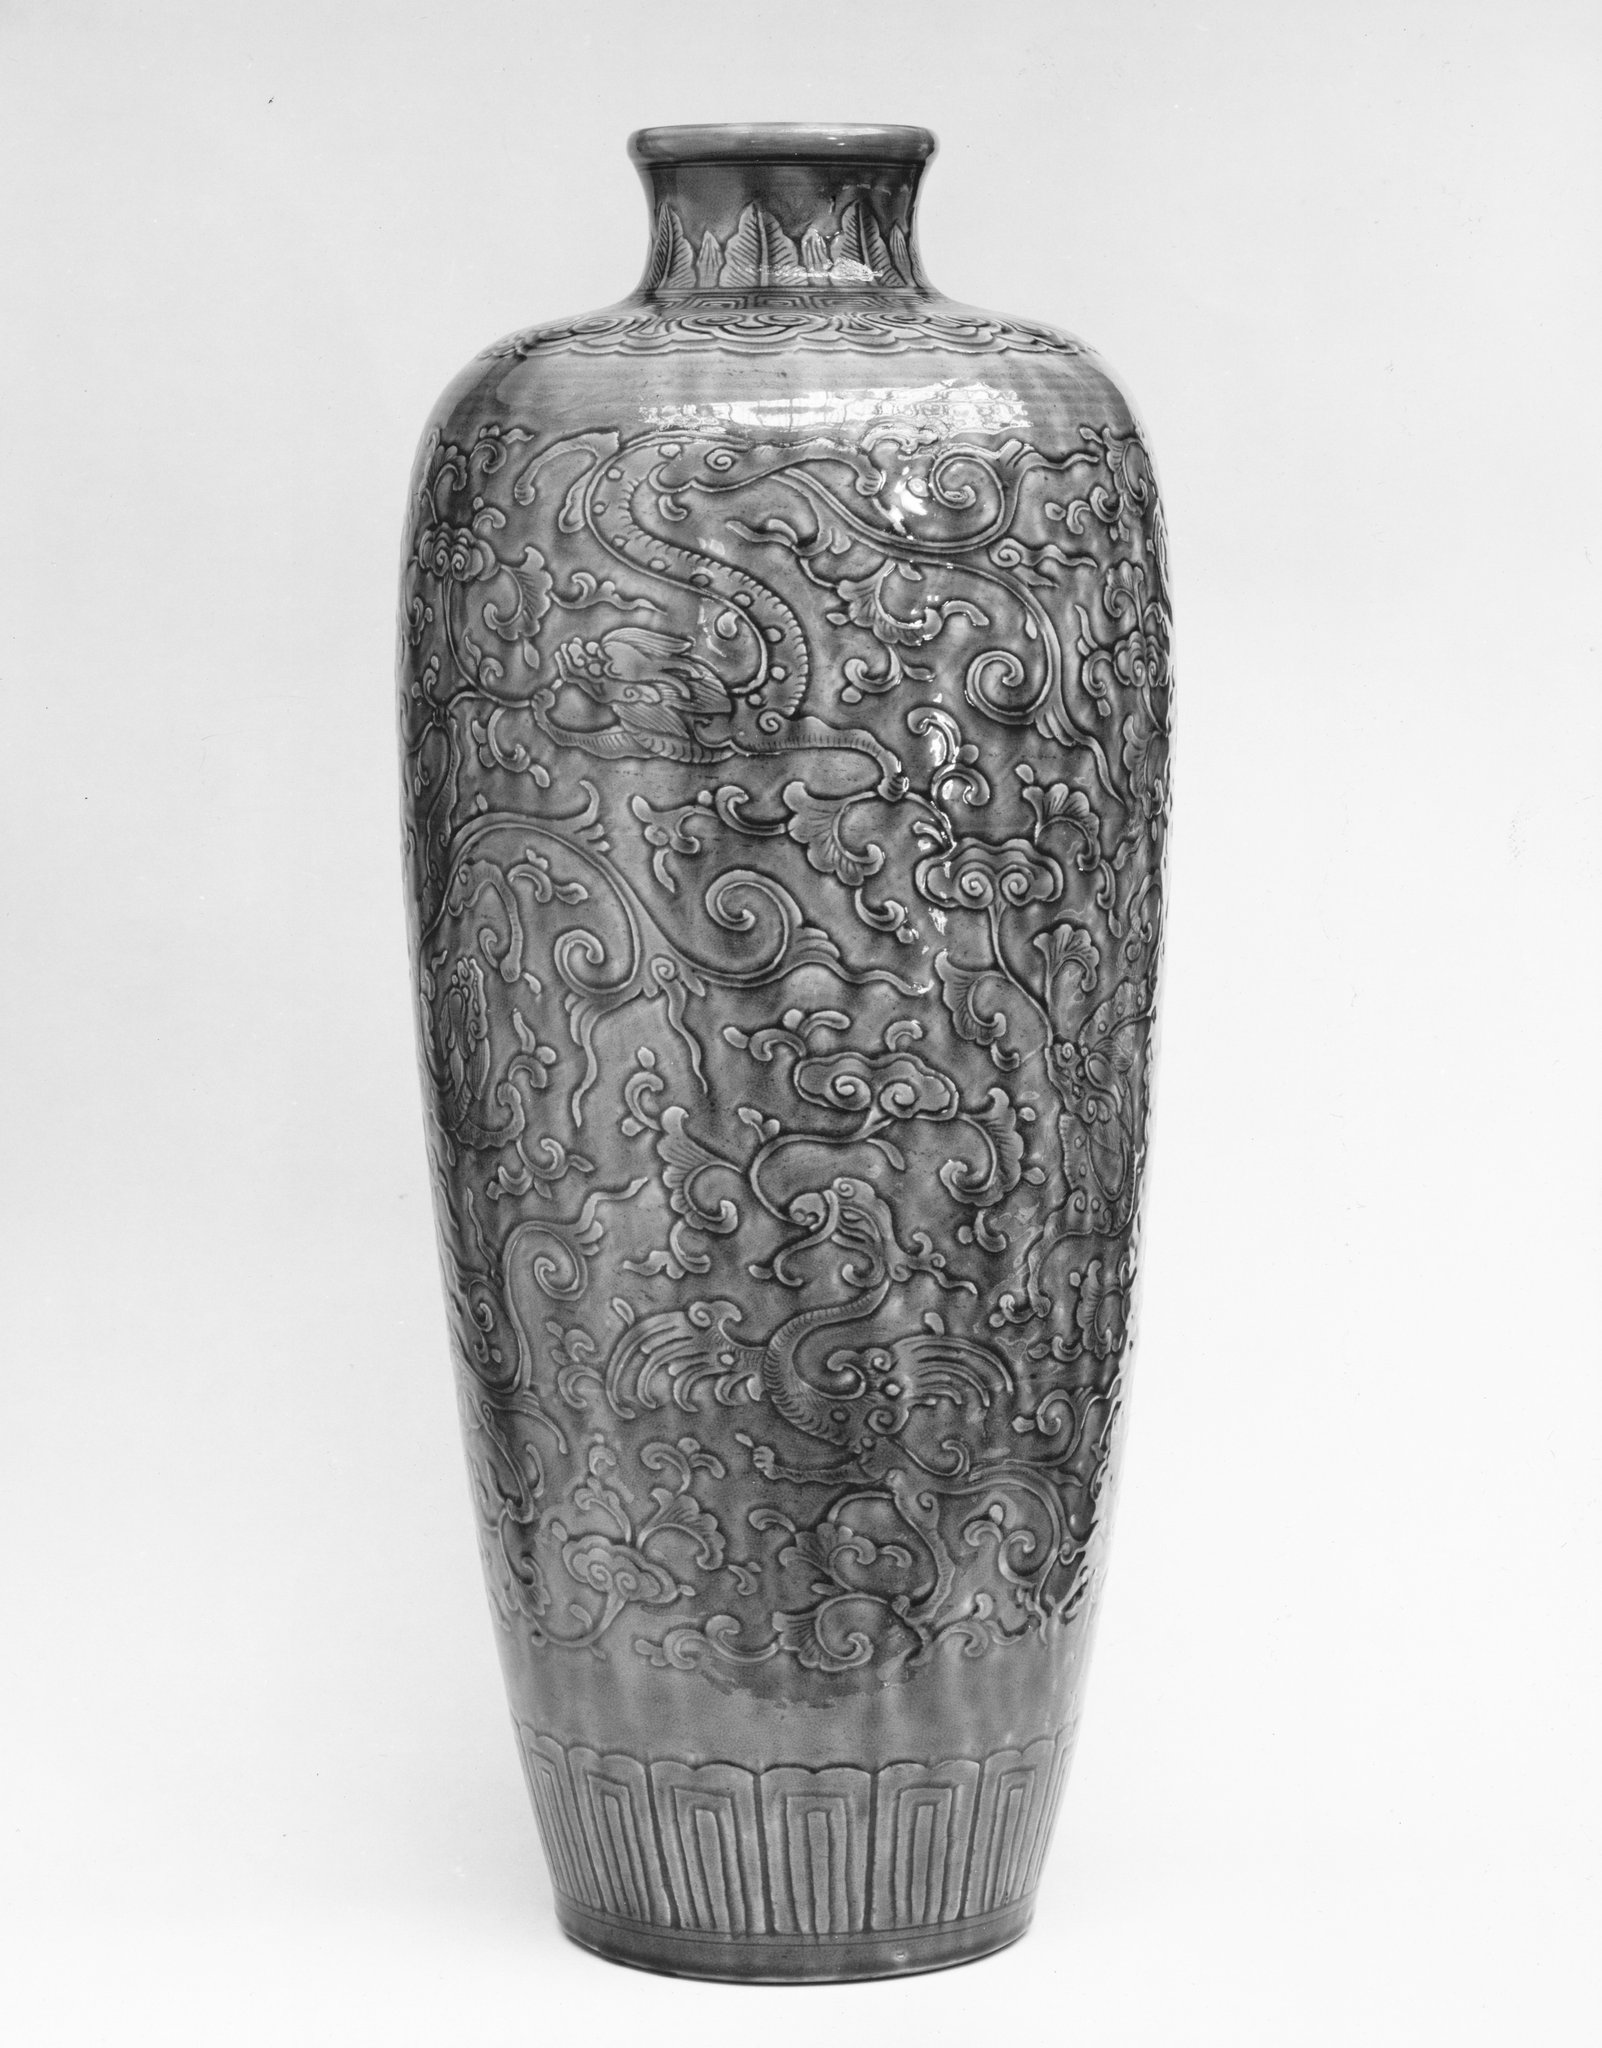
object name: vase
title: Vase with chi dragons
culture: chinese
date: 1734-1766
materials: glaze, porcelain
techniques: relief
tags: dragons